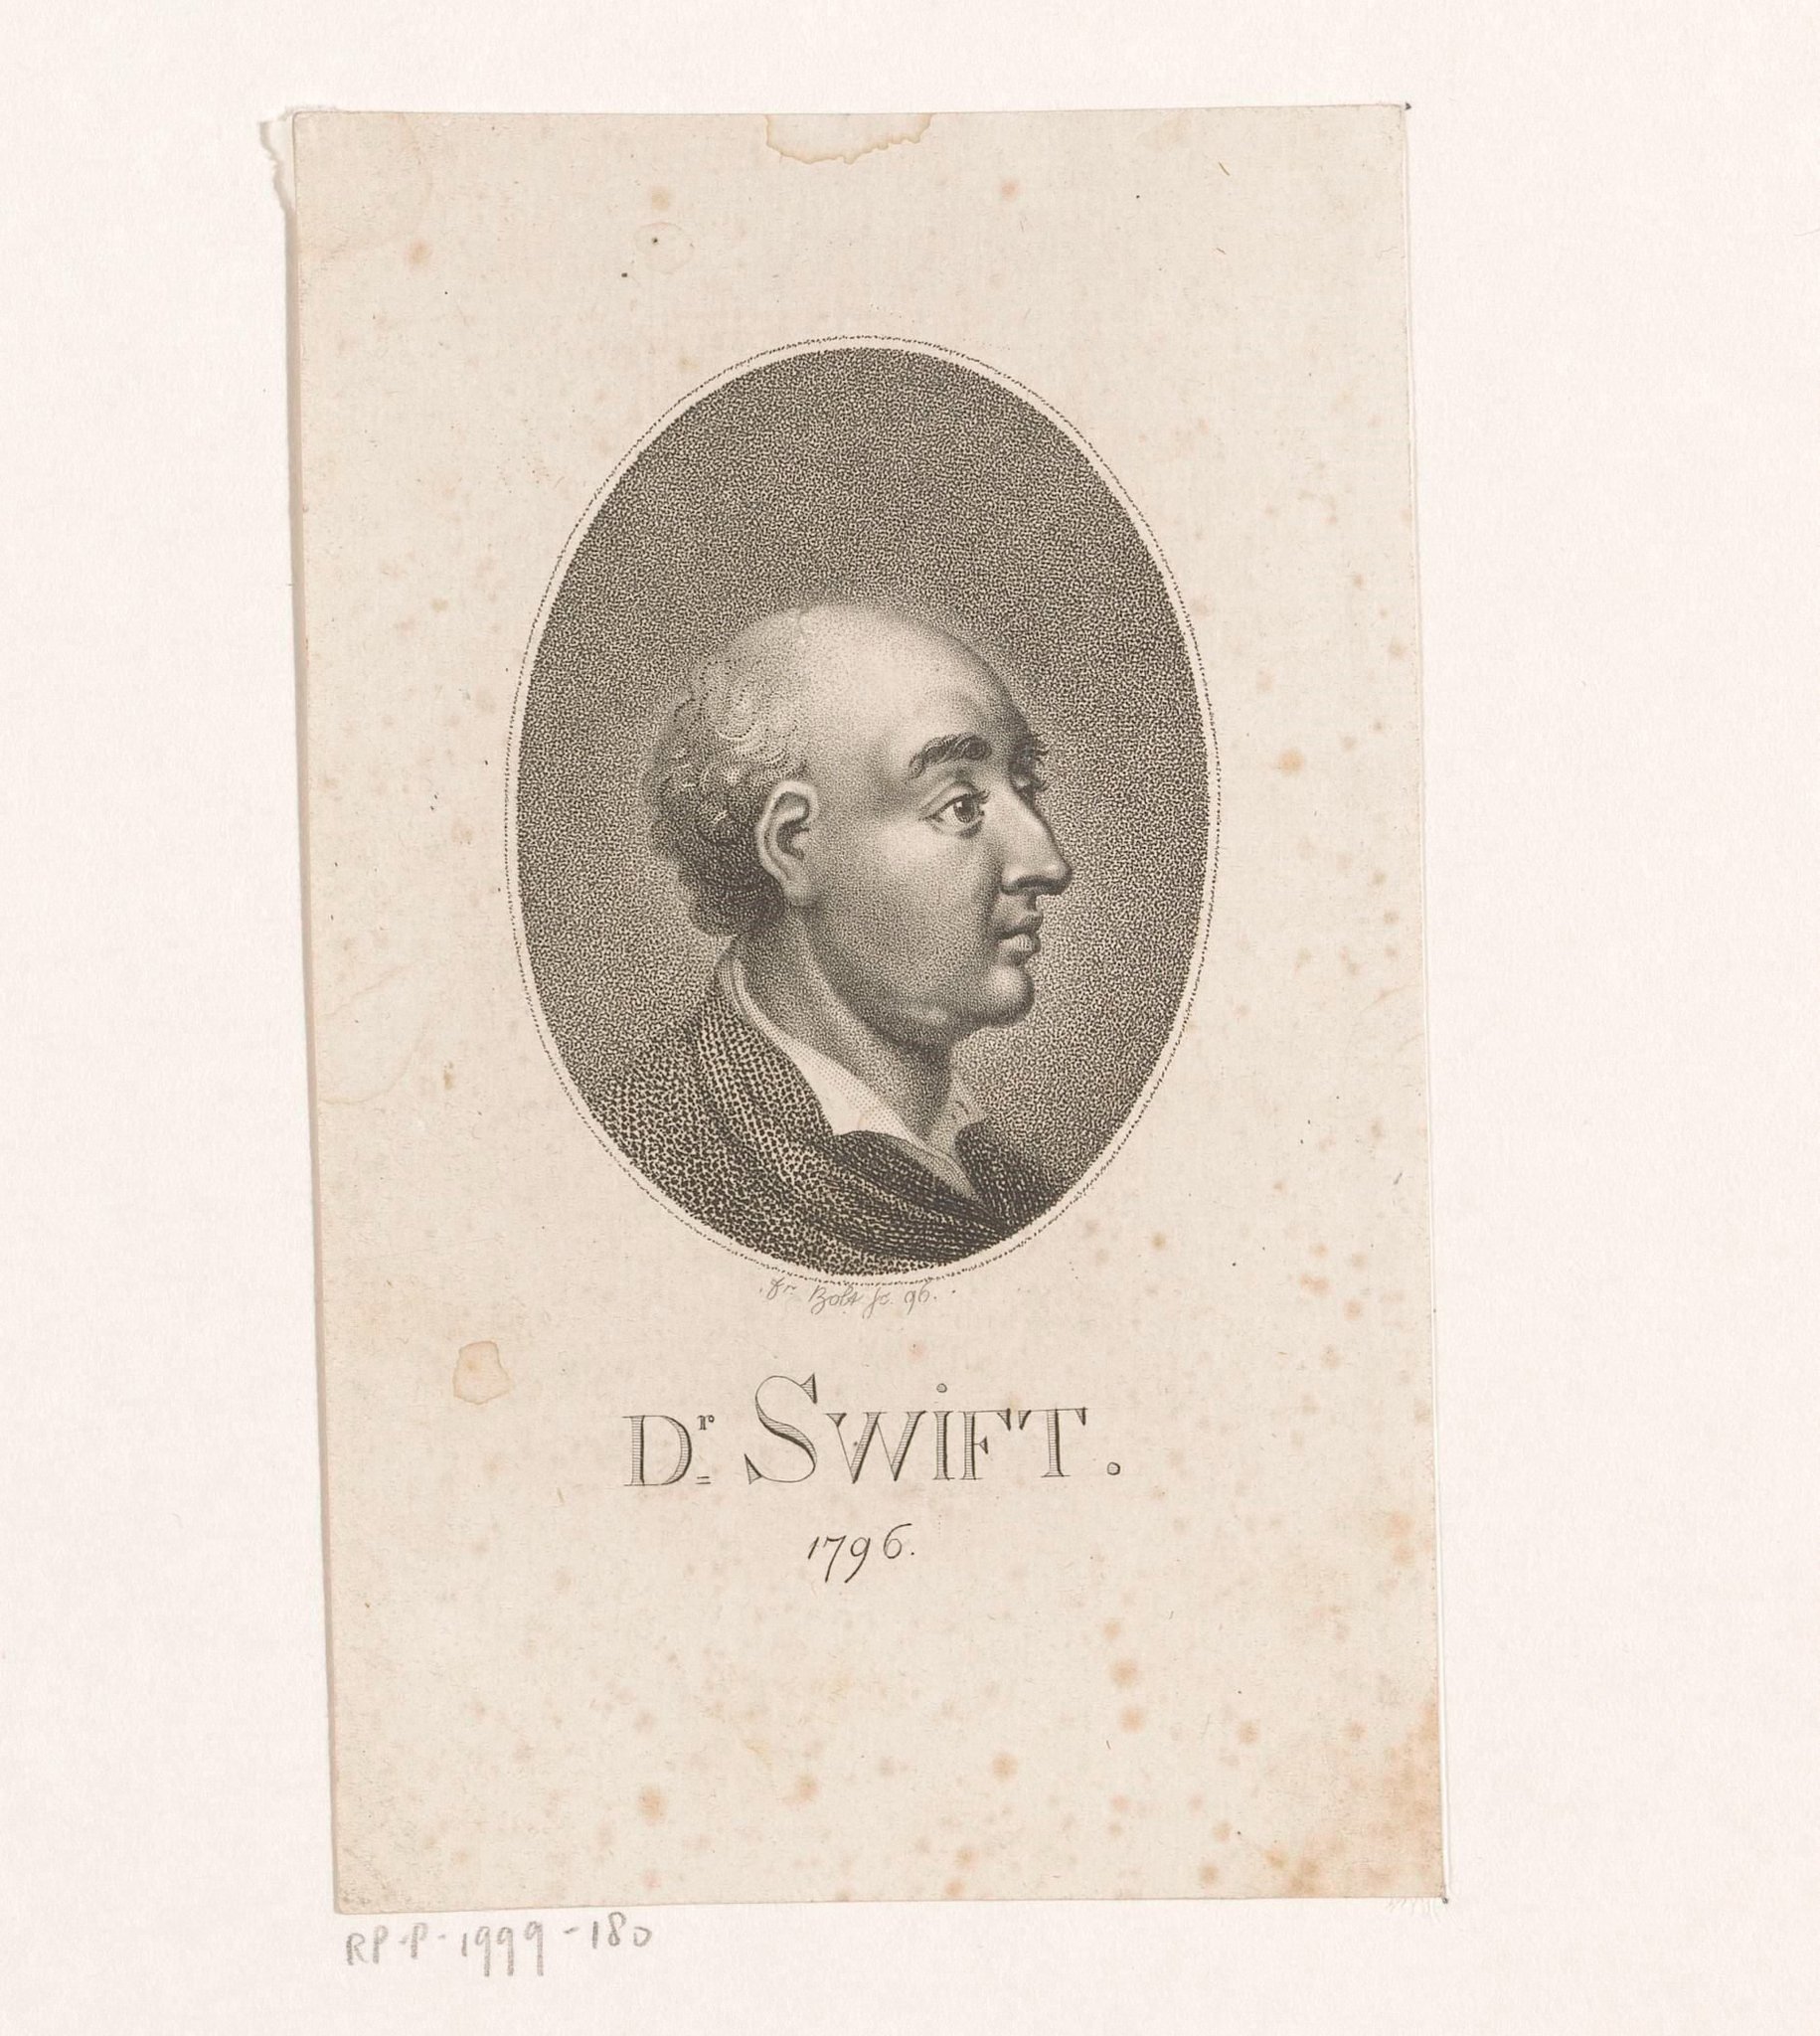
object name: print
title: Portret van Jonathan Swift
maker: johann friedrich bolt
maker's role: print maker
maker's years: 1769-1836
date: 1796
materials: paper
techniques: stippling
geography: berlin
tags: historical persons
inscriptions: collector's mark: Lugt 2228, collector's mark: Lugt 2760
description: Prent mogelijk ook gebruikt in: Archenholz, Johann Wilhelm von. Annalen der Brittischen Geschichte.